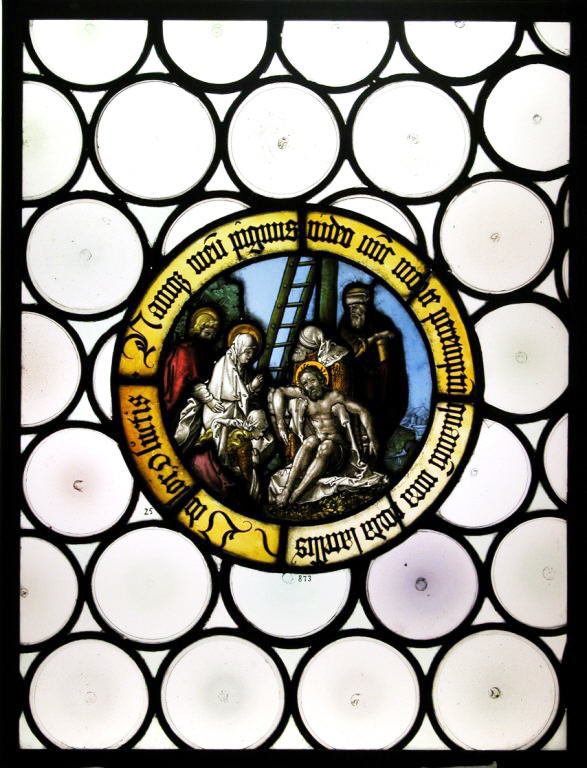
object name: panel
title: The Deposition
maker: sebald beham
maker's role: artist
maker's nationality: german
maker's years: 1500-1550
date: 1525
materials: glass, metal, paint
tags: jesus,descent from the cross